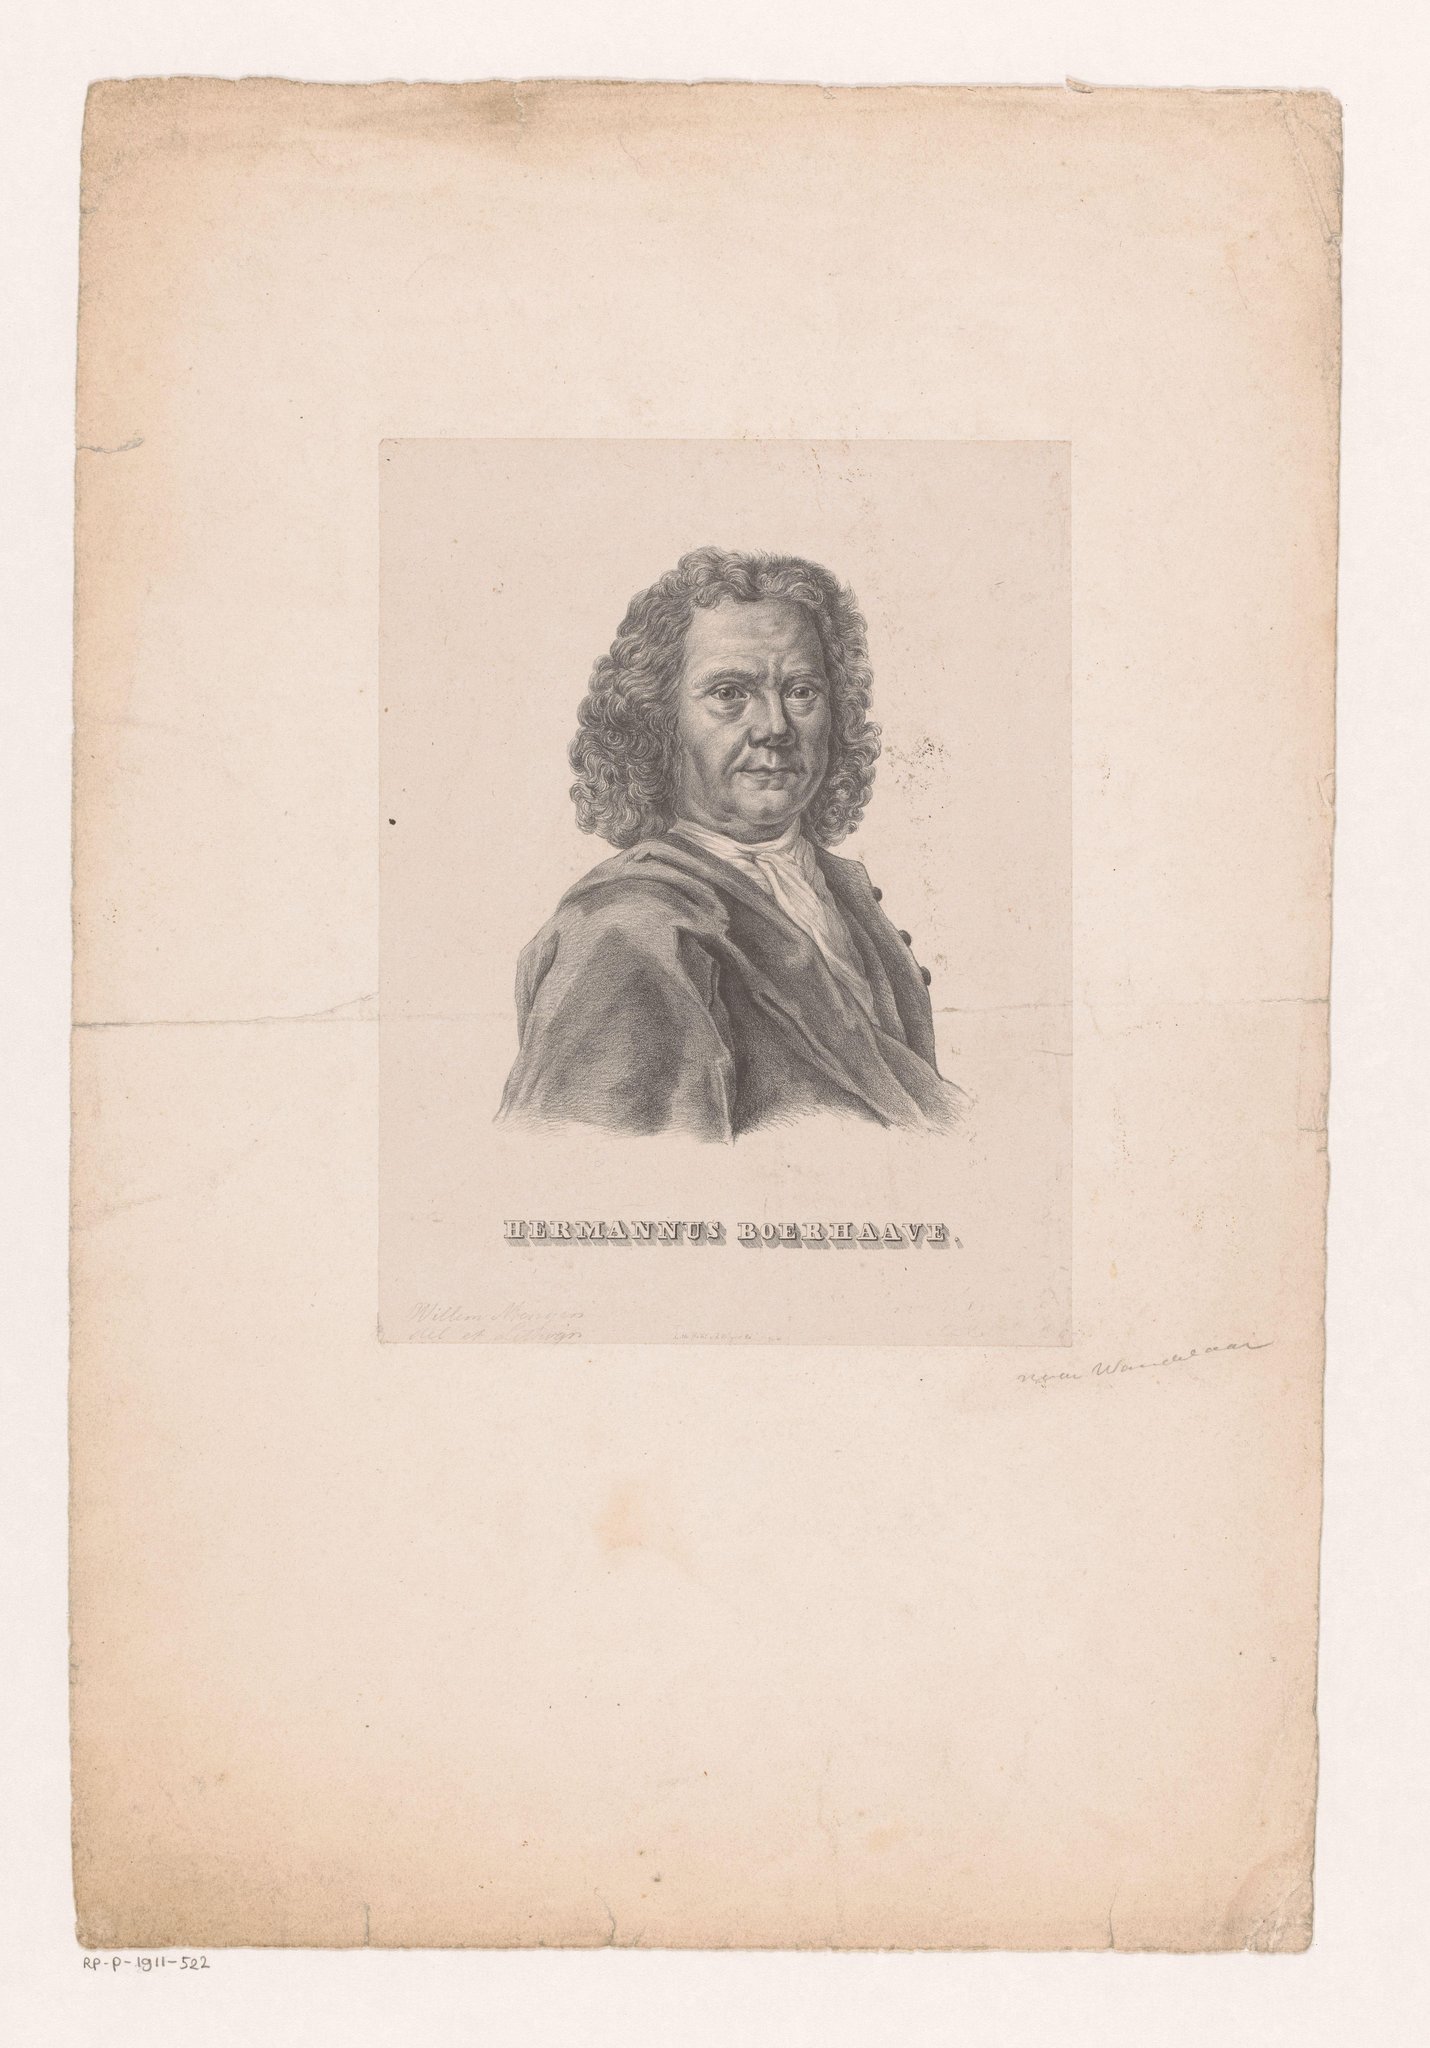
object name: print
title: Portret van Herman Boerhaave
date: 1816-1860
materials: paper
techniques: lithograph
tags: leiden, hermanus boerhaave, historical persons (+ (full) bust portrait)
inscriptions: collector's mark: Lugt 2228